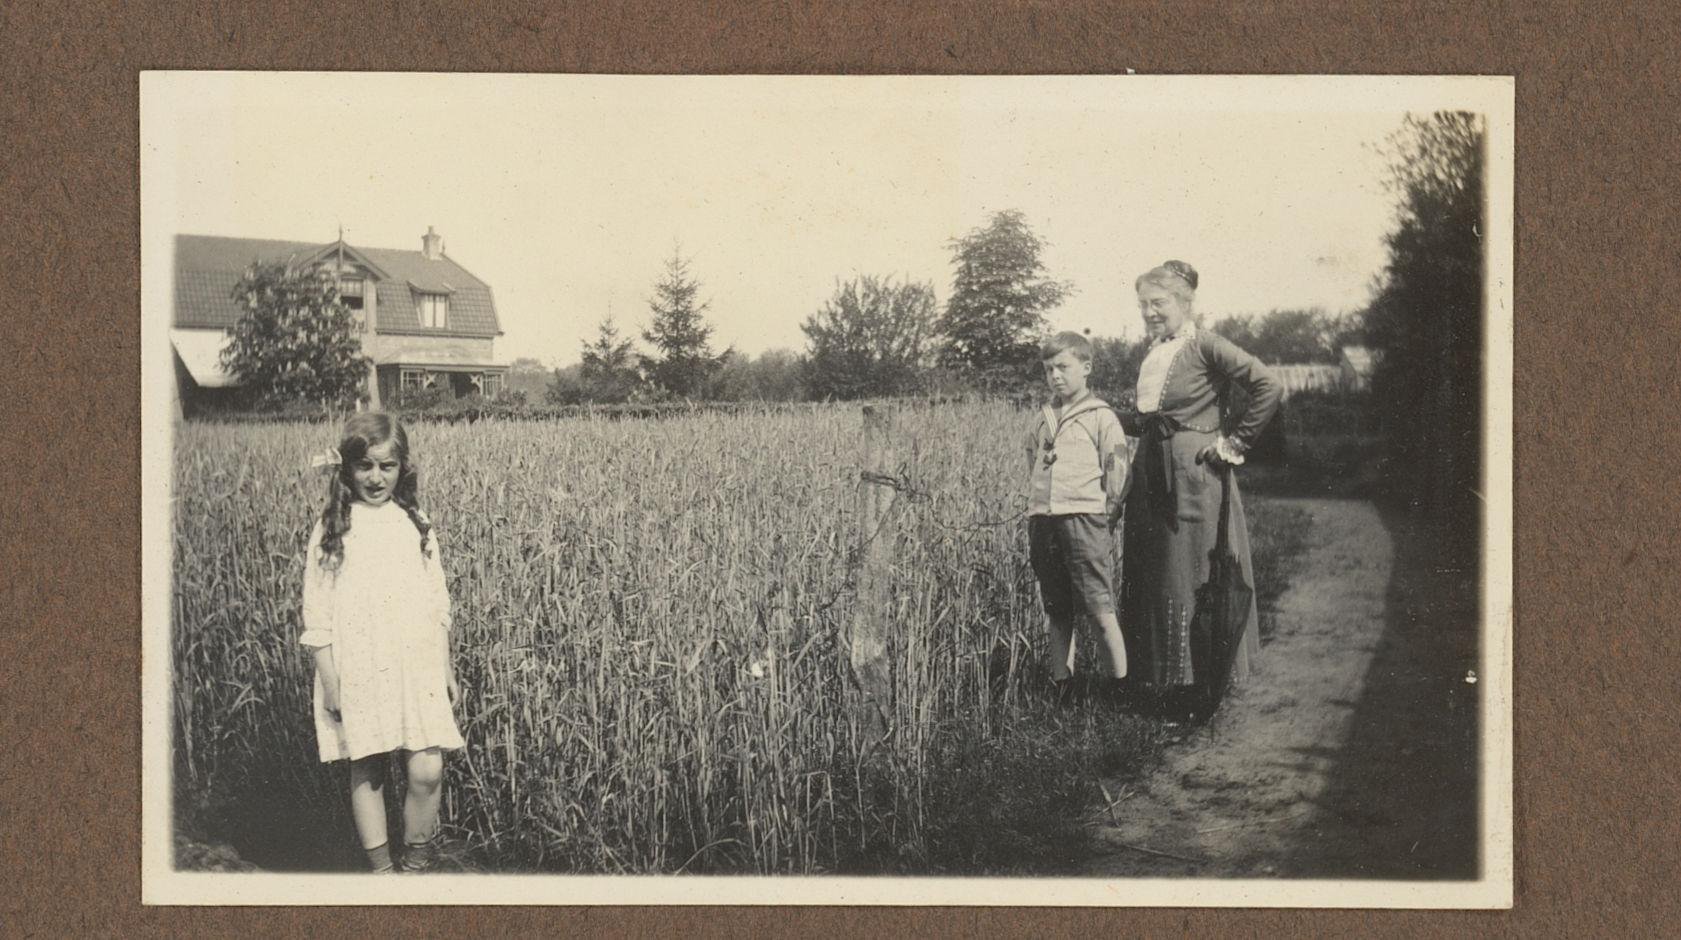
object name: photograph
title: Twee kinderen en een vrouw bij een korenveld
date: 1900-1915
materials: photographic support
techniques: photography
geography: netherlands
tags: netherlands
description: Foto op bruin albumblad 52 van familiealbum van Alphons Diepenbrock.